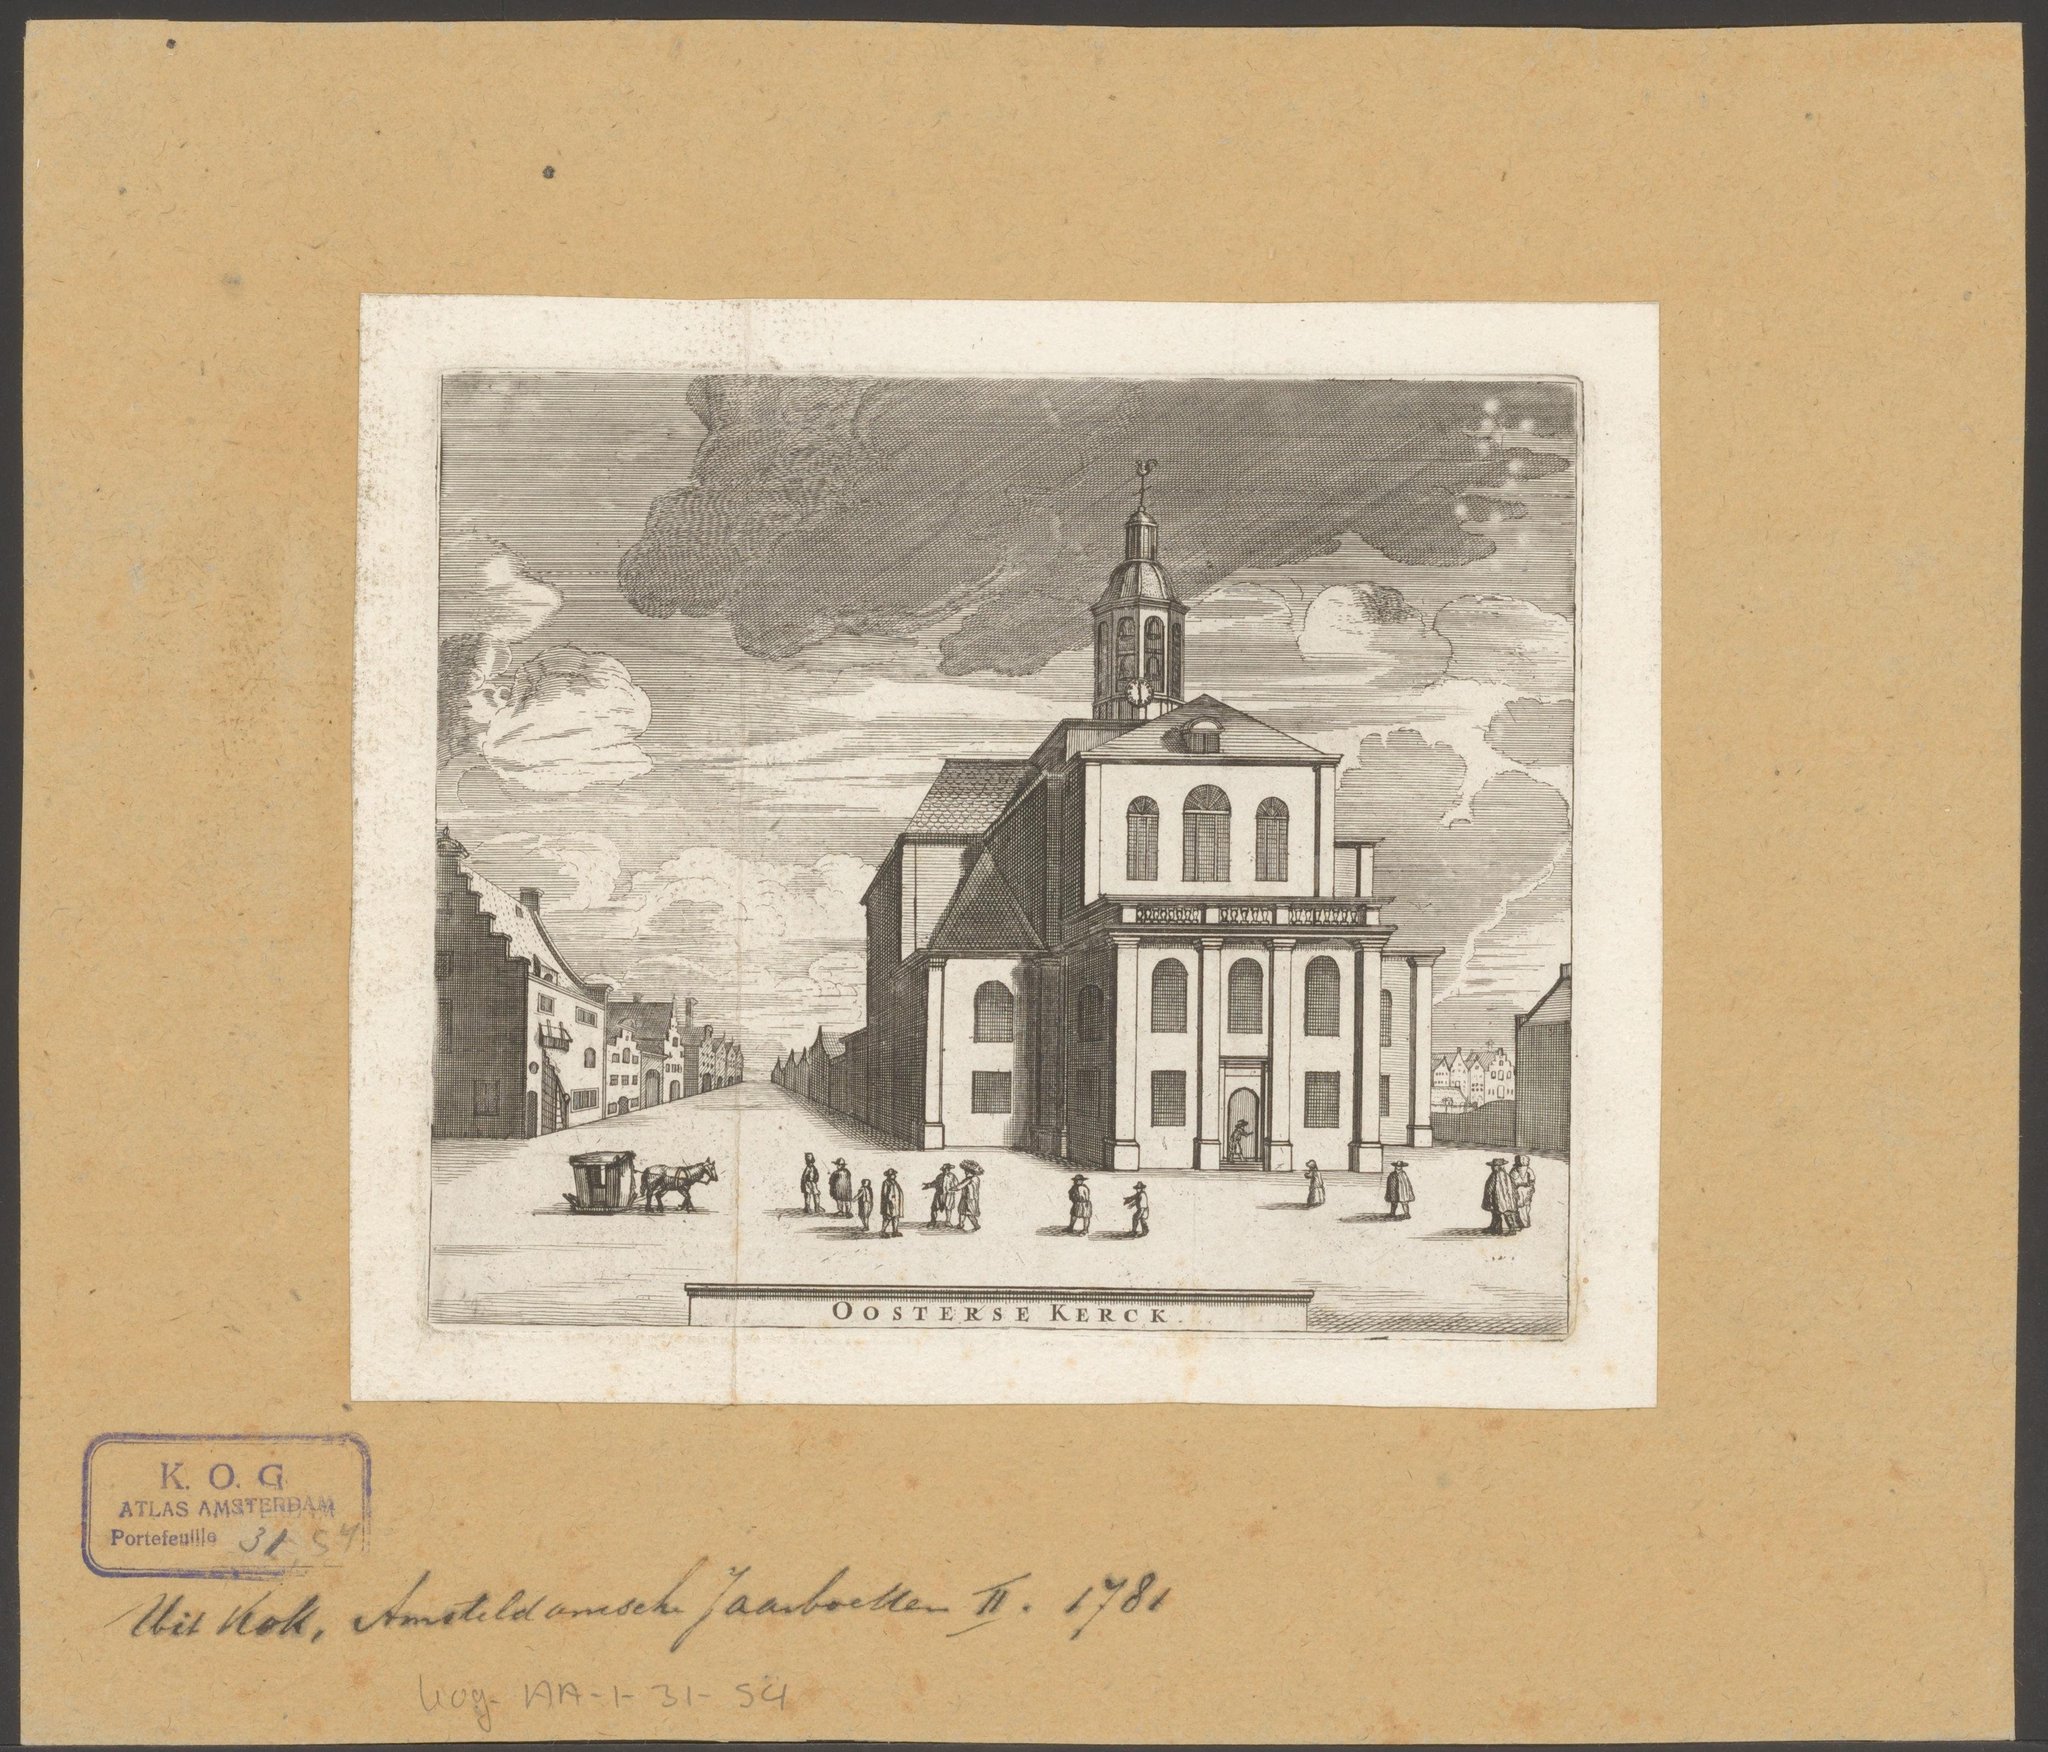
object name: print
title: Gezicht op de Oosterkerk te Amsterdam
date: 1781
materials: paper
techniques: engraving, etching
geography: northern netherlands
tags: church (exterior), street (+ city(-scape) with figures, staffage)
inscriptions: collector's mark: Lugt 1641b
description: Prent mogelijk uit: Kok, Jacobus. Amsteldamsche jaarboeken, behelzende de merkwaardigste geschiedenissen (...). Amsterdam: Jan Barend Elwe, 1781, dl. 2.